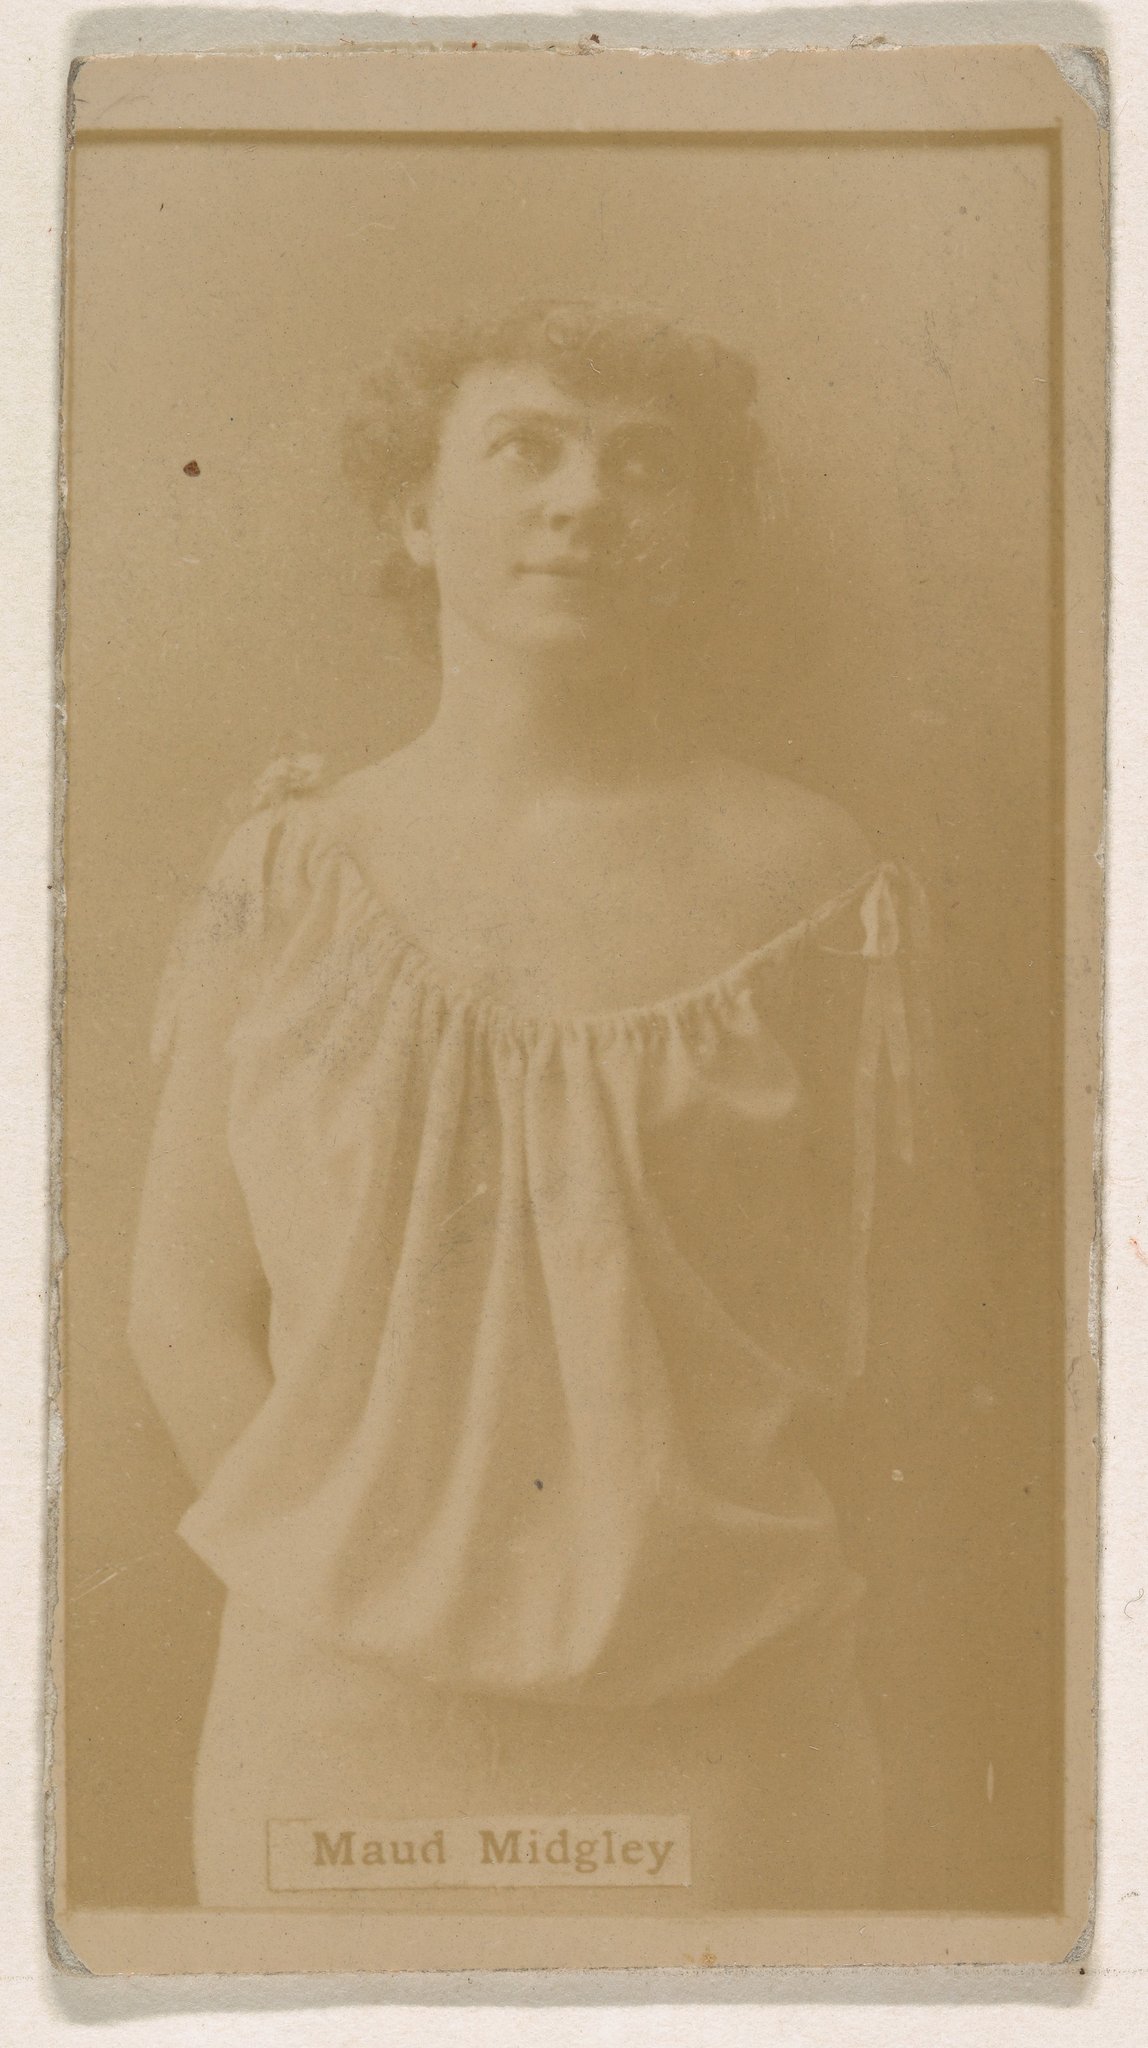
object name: photograph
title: Maud Midgley, from the Actresses series (N245) issued by Kinney Brothers to promote Sweet Caporal Cigarettes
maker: kinney brothers tobacco company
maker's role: publisher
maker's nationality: american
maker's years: 1869-2011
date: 1890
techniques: albumen silver print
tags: portraits,women,actresses